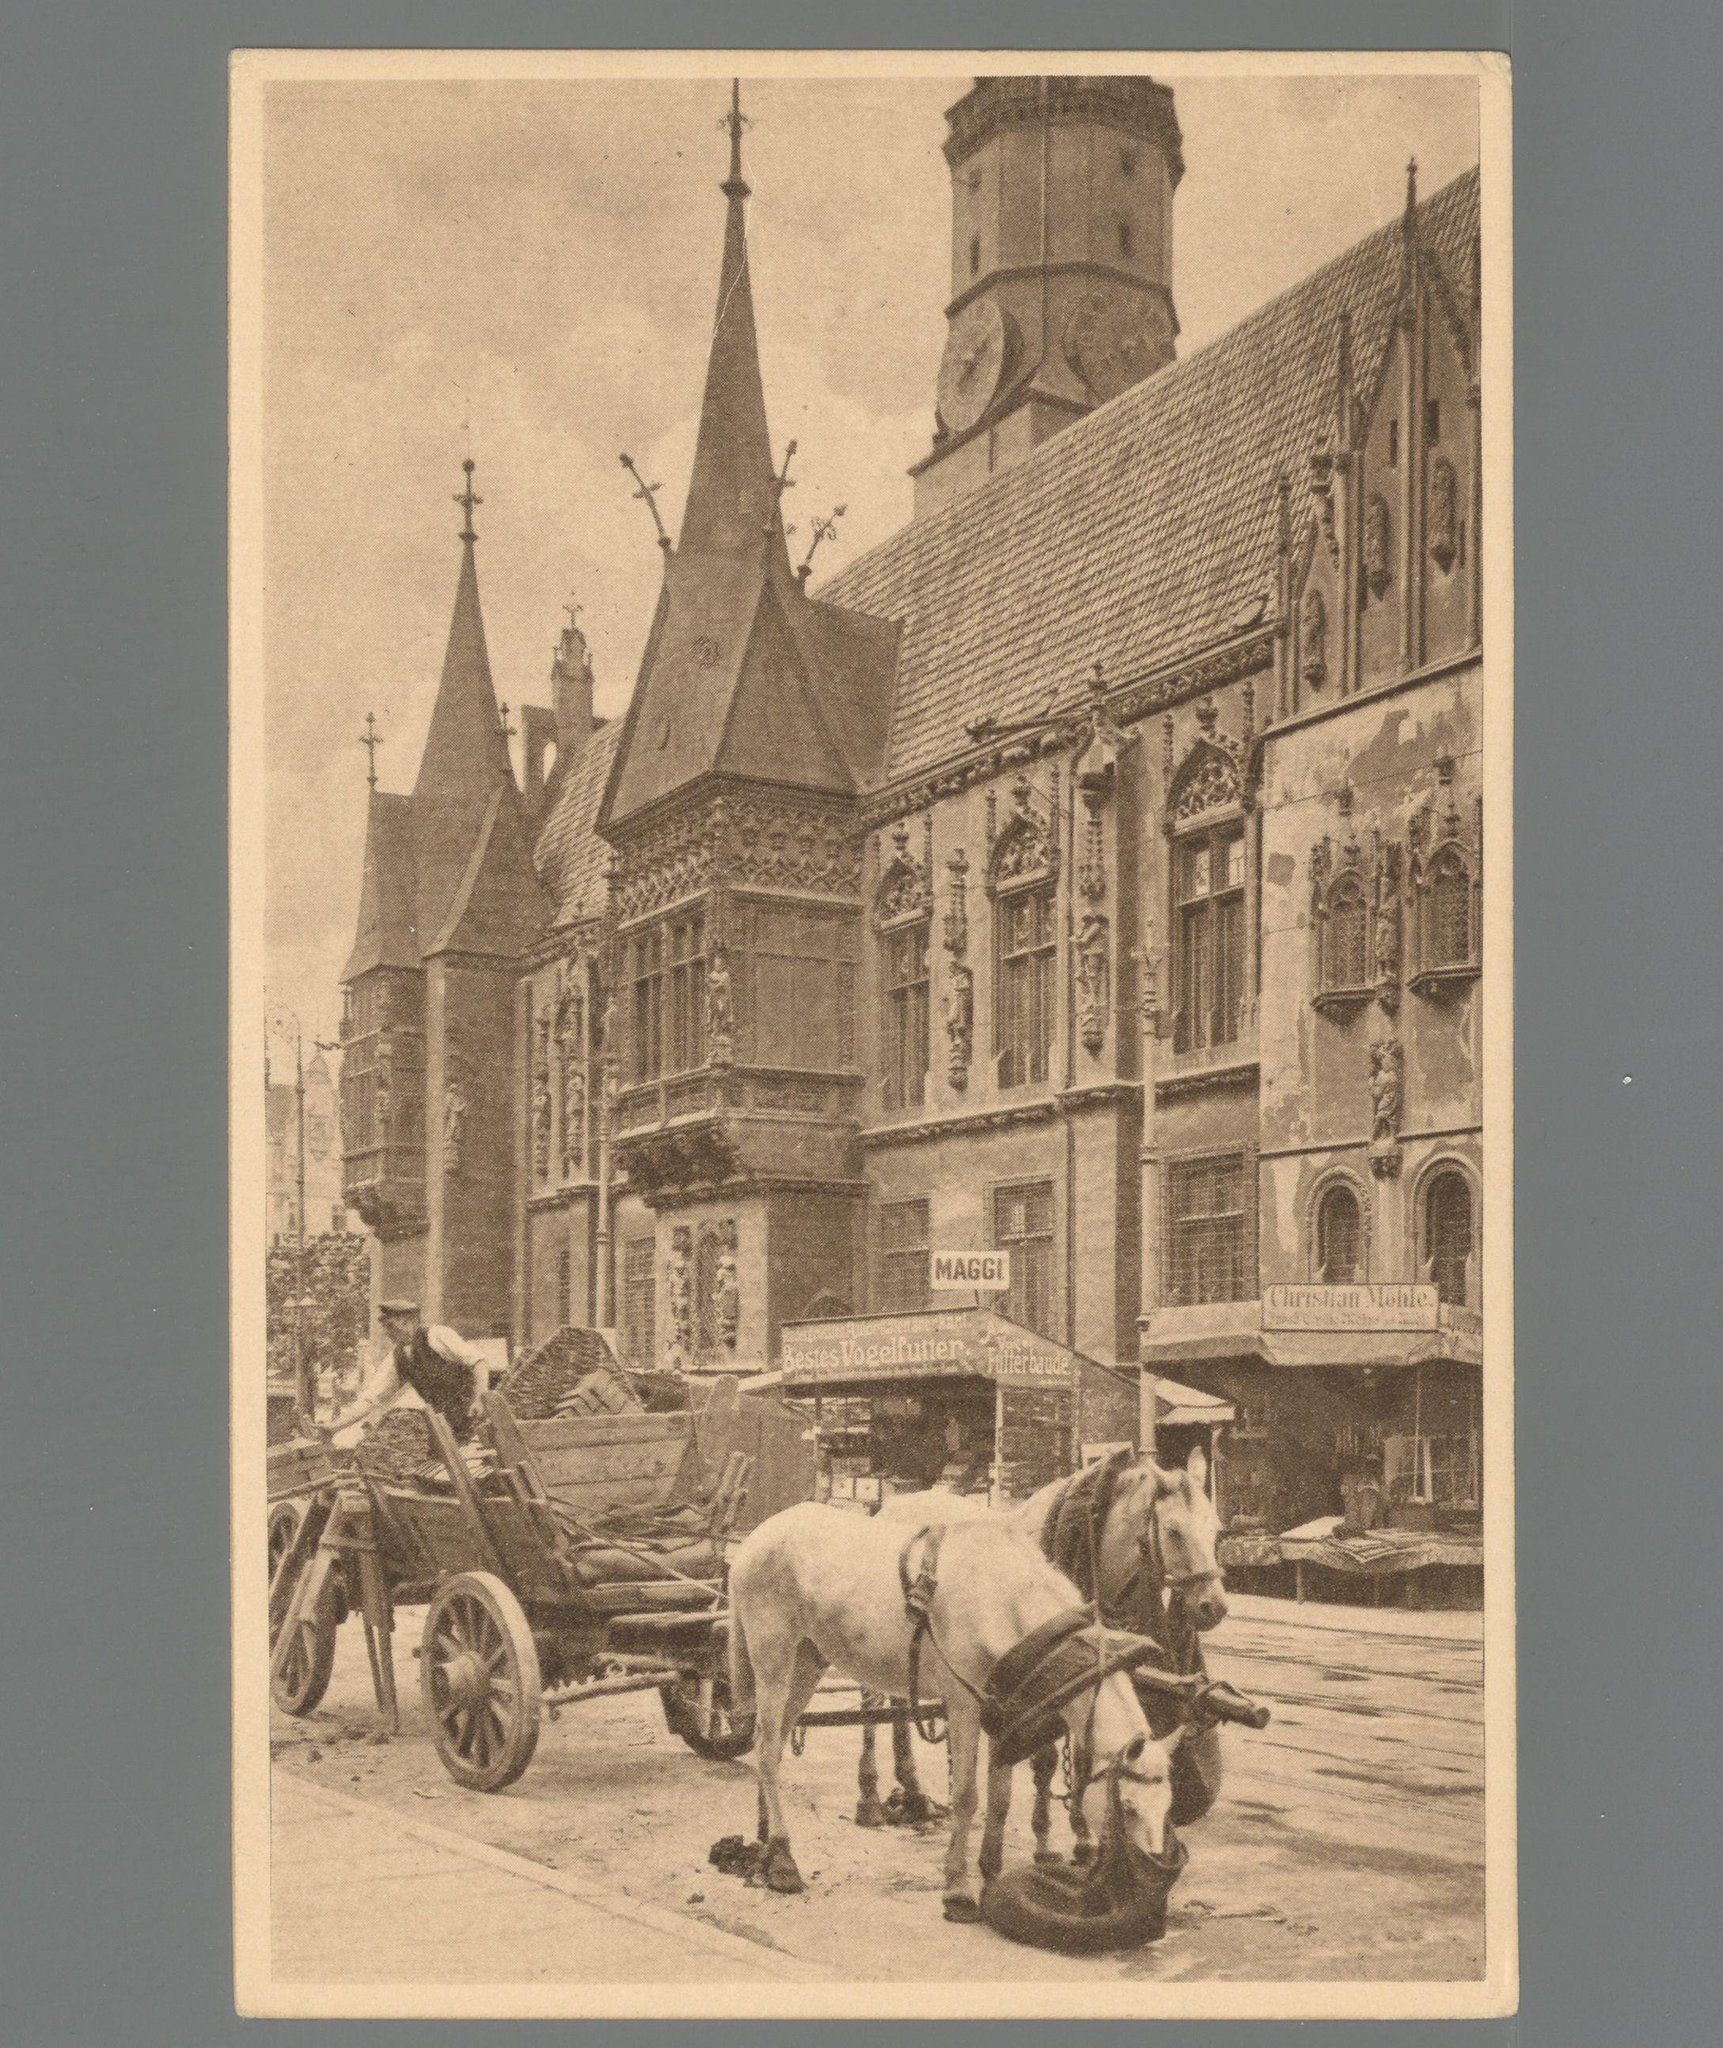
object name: ansichtkaart, prentbriefkaart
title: Breslau, Am Rathaus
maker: Anonymous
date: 1905-1930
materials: cardboard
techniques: rotogravure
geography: breslau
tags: townhall, four-wheeled vehicle drawn by two animals